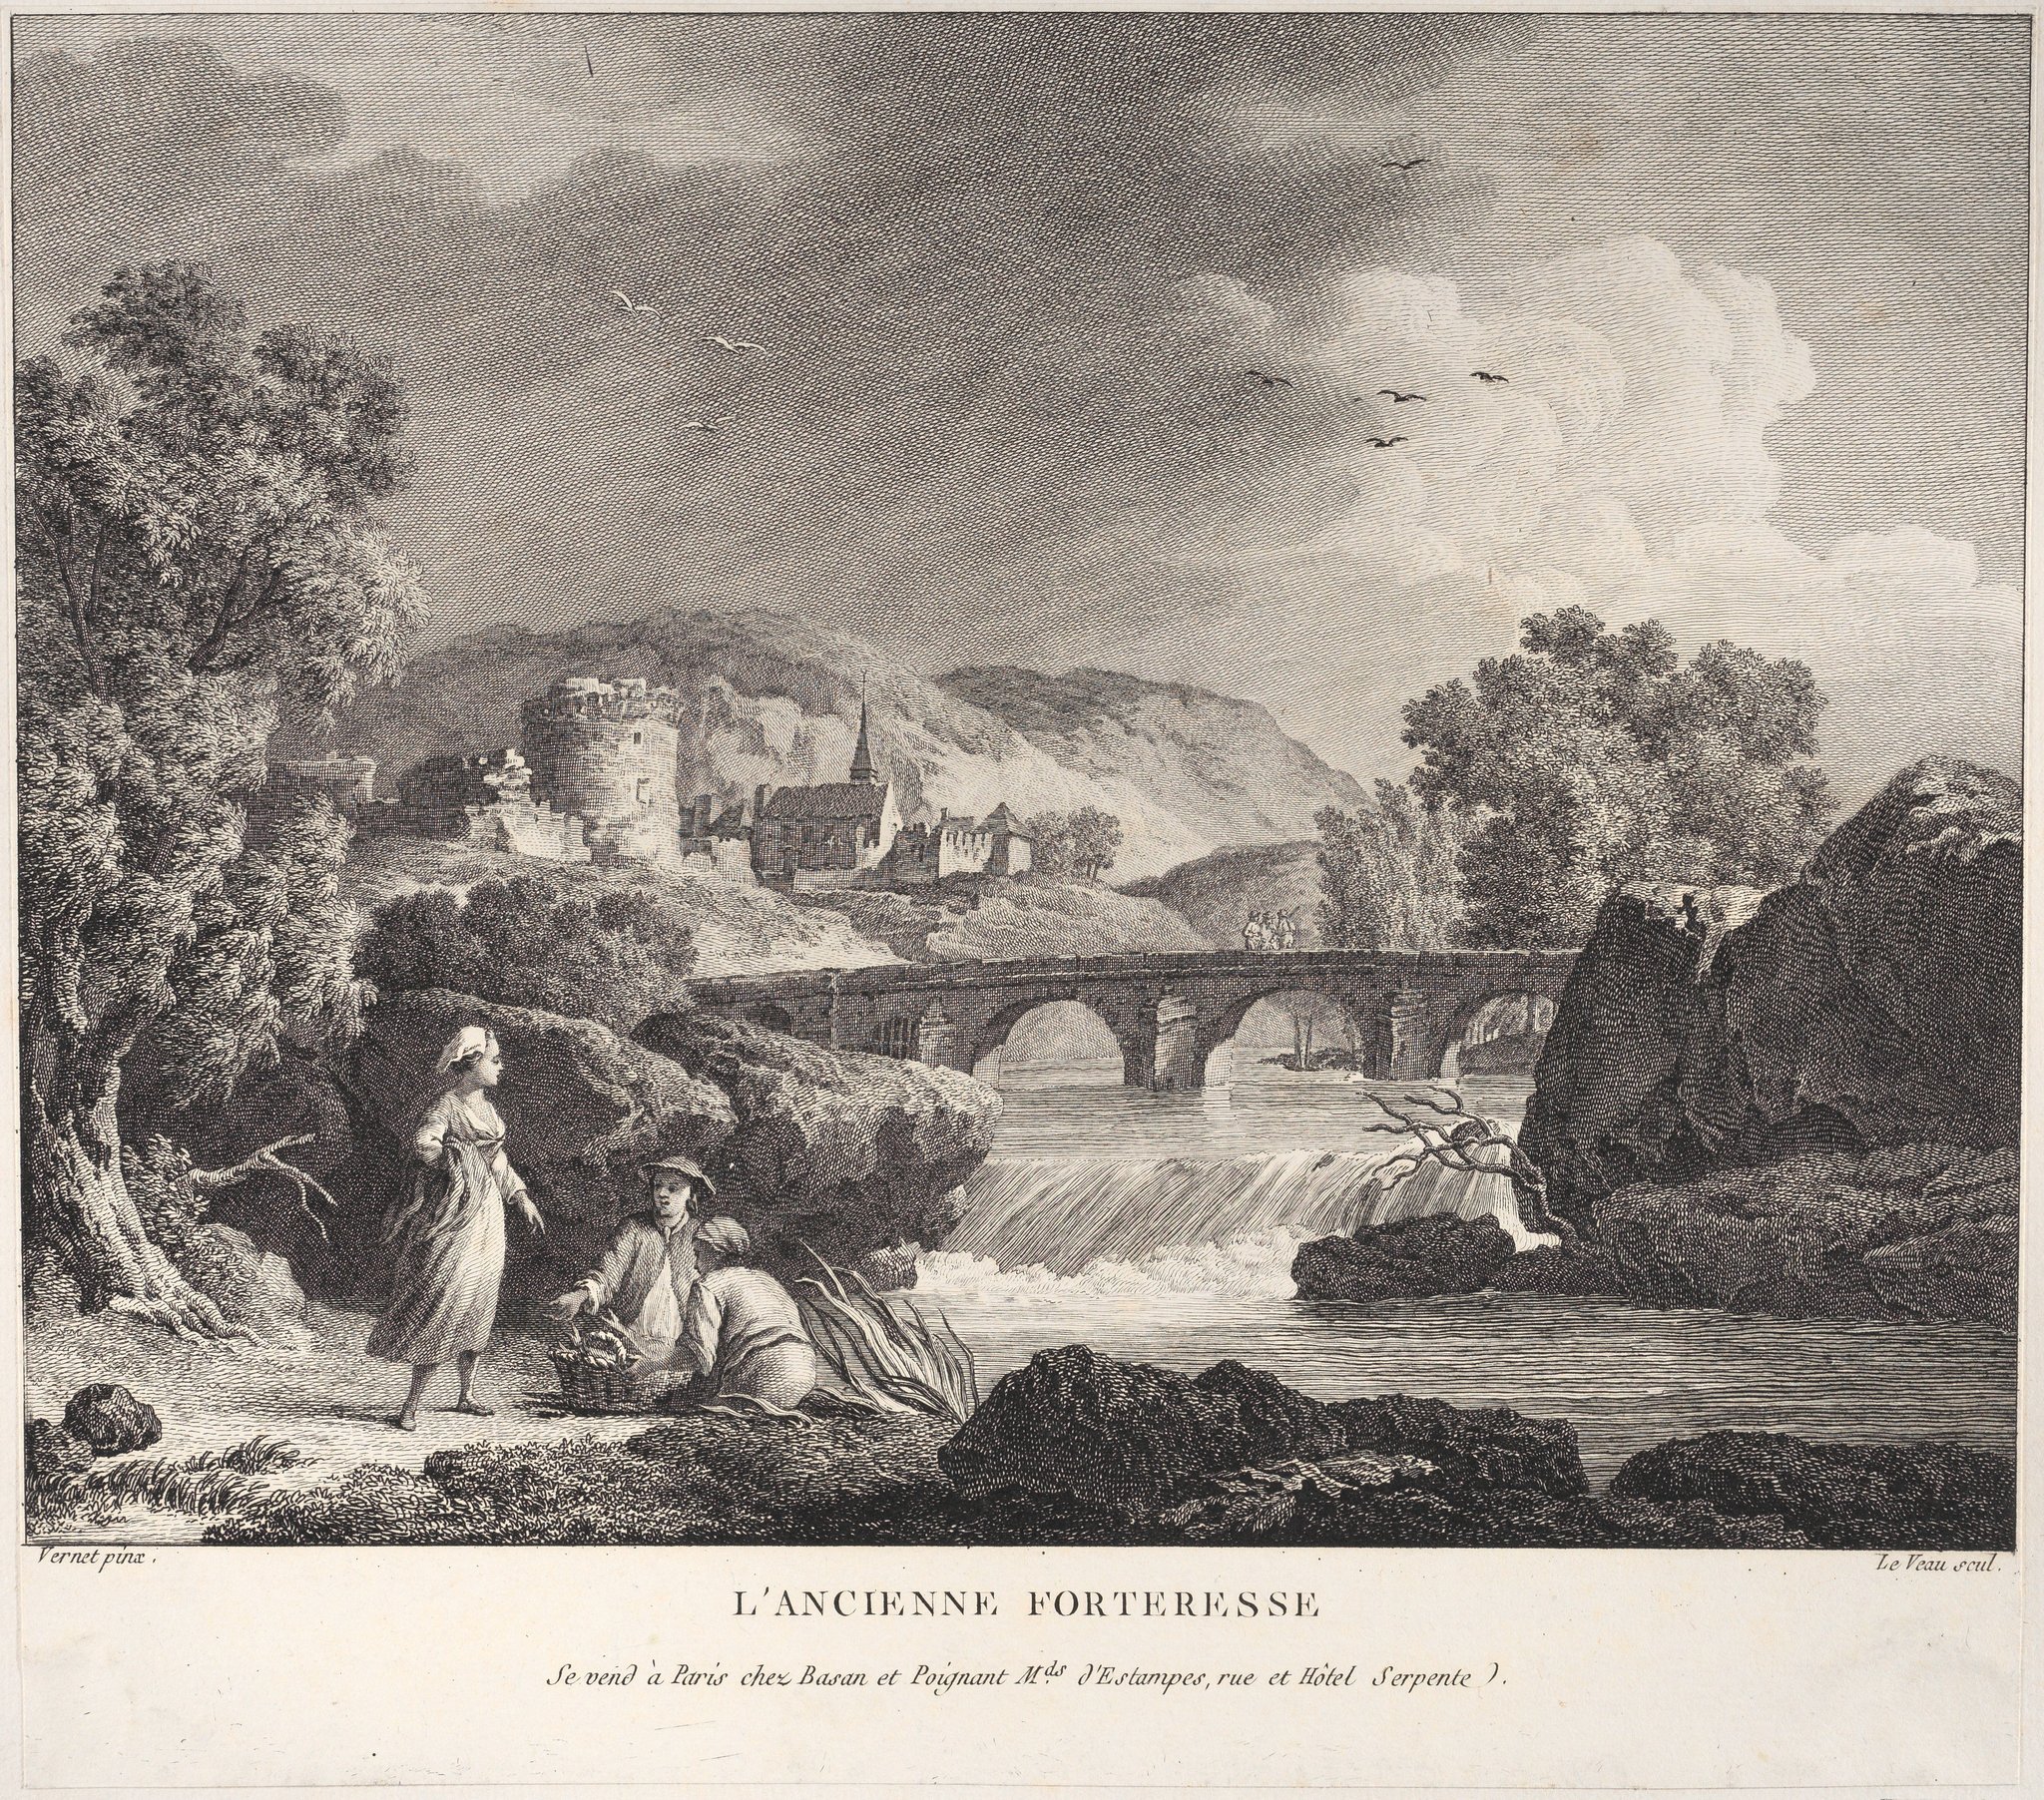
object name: print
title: The Old Fortress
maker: joseph vernet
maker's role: artist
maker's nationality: french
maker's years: 1714-1789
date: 1770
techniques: engraving